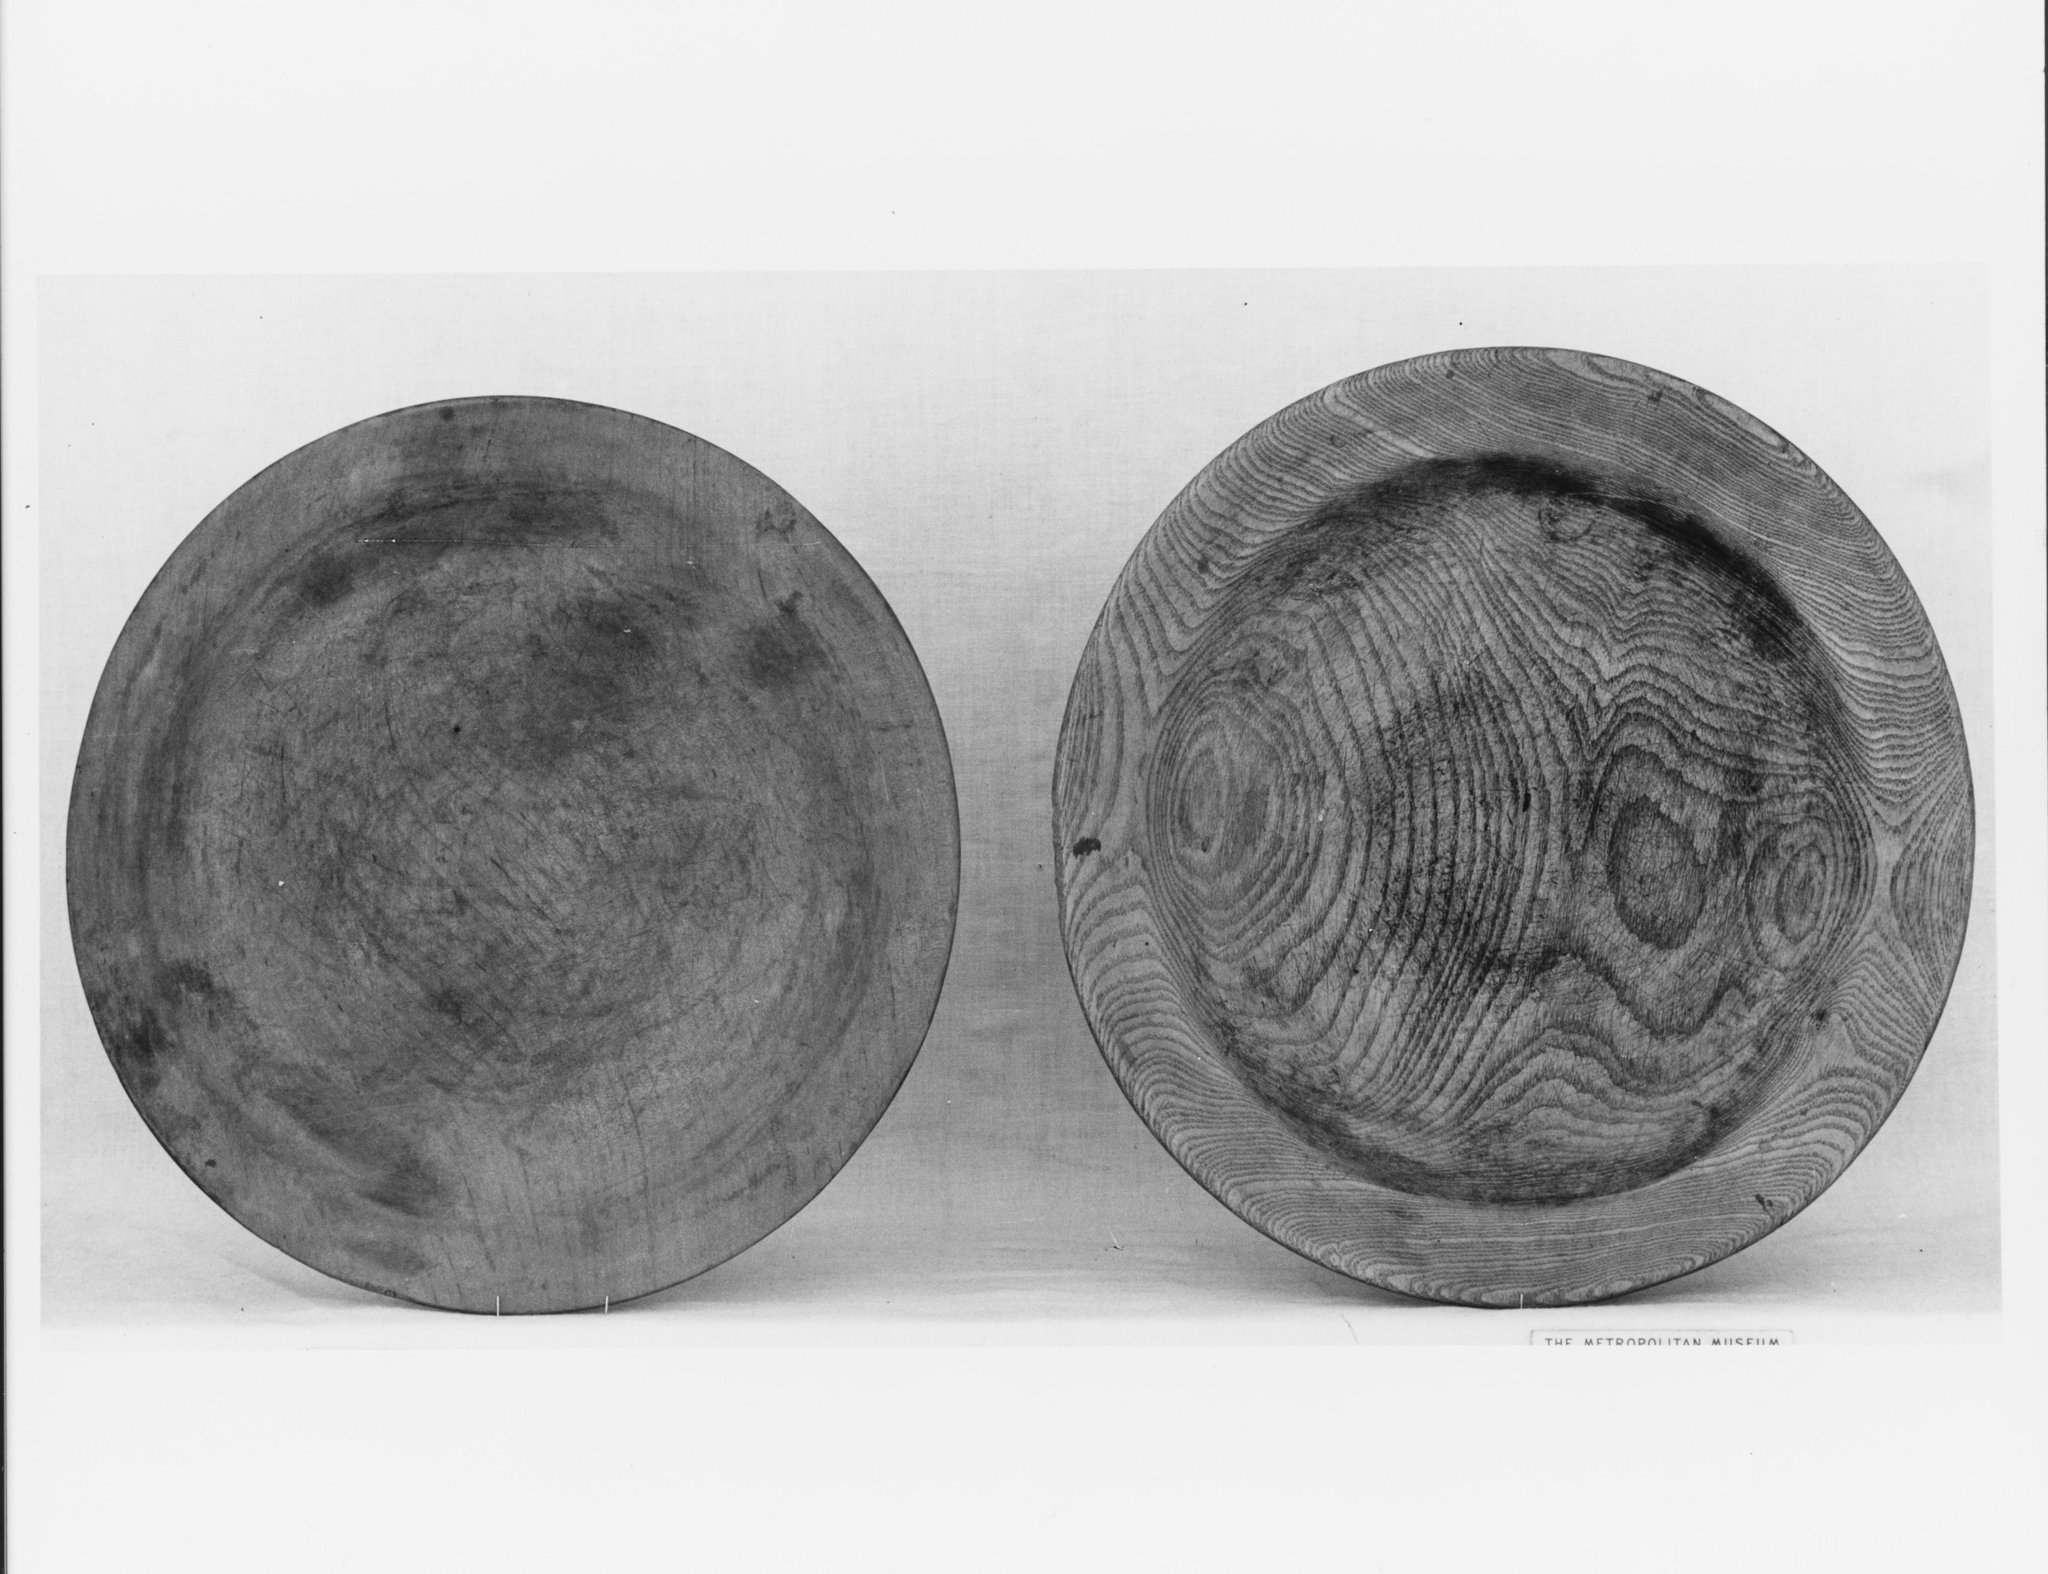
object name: plate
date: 1600-1800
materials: wood